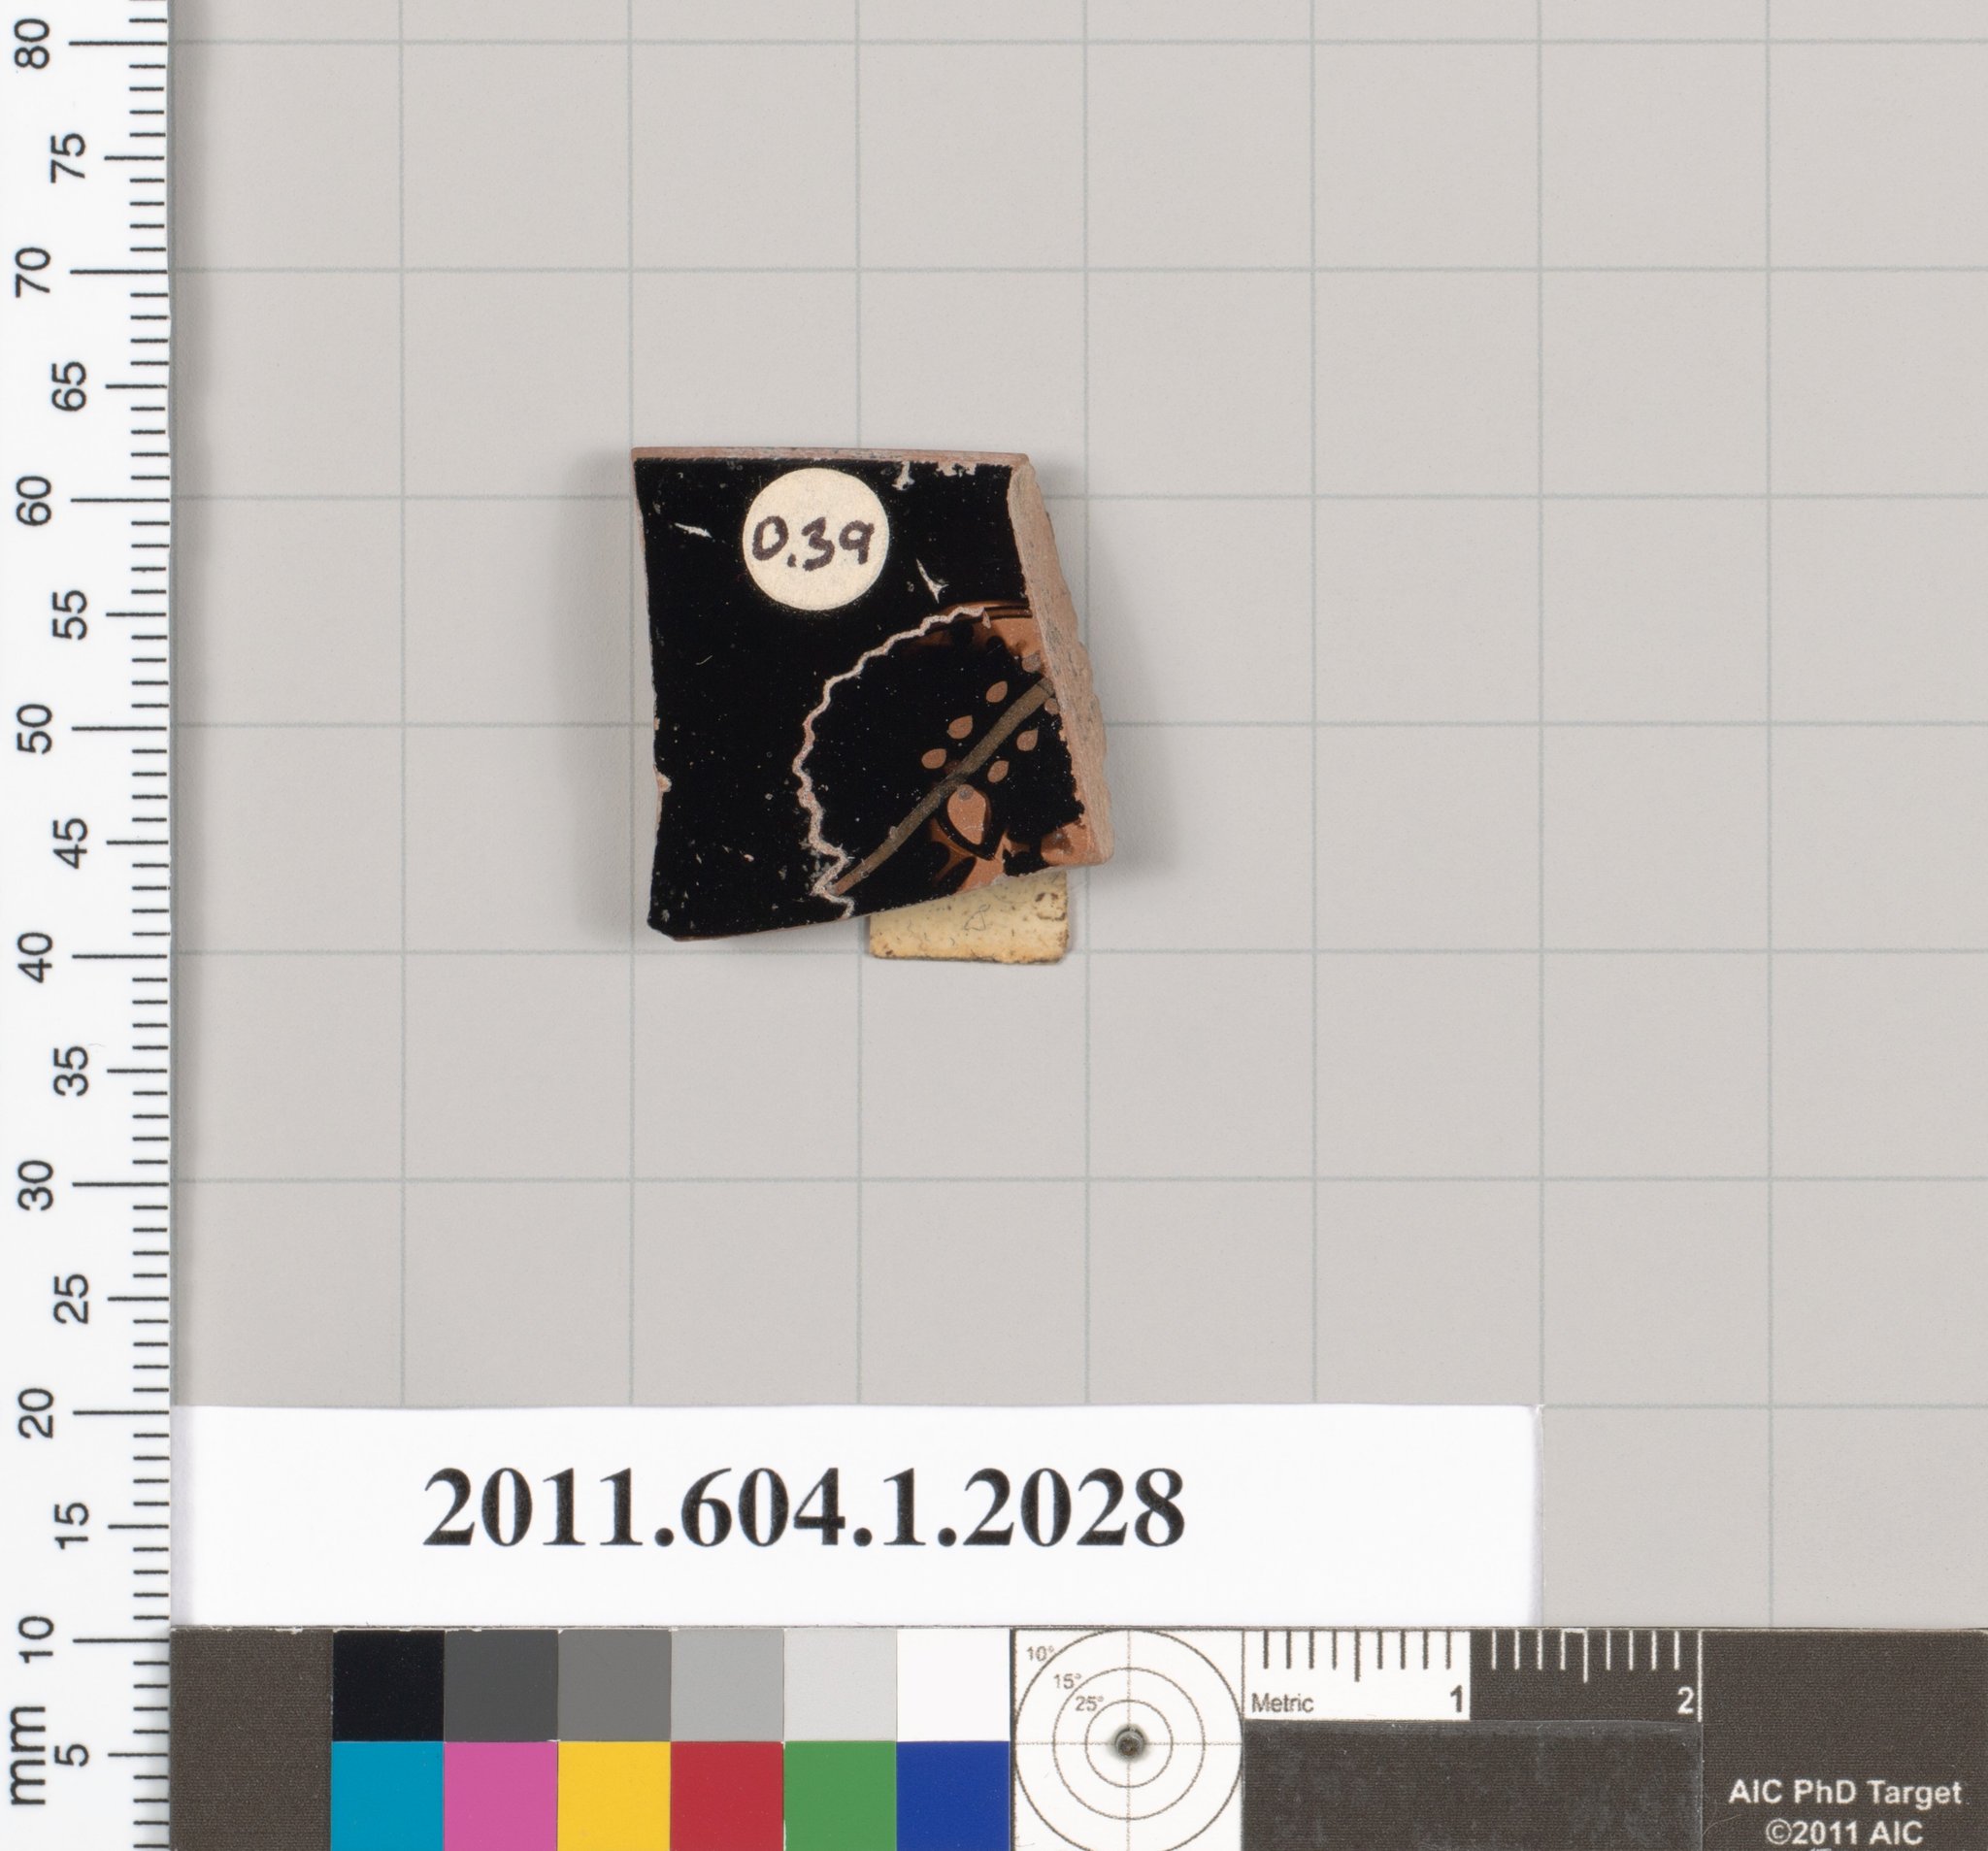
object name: kylix fragment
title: Terracotta rim fragment of a kylix (drinking cup)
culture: greek, attic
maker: skythes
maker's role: artist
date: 534-468 BCE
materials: terracotta